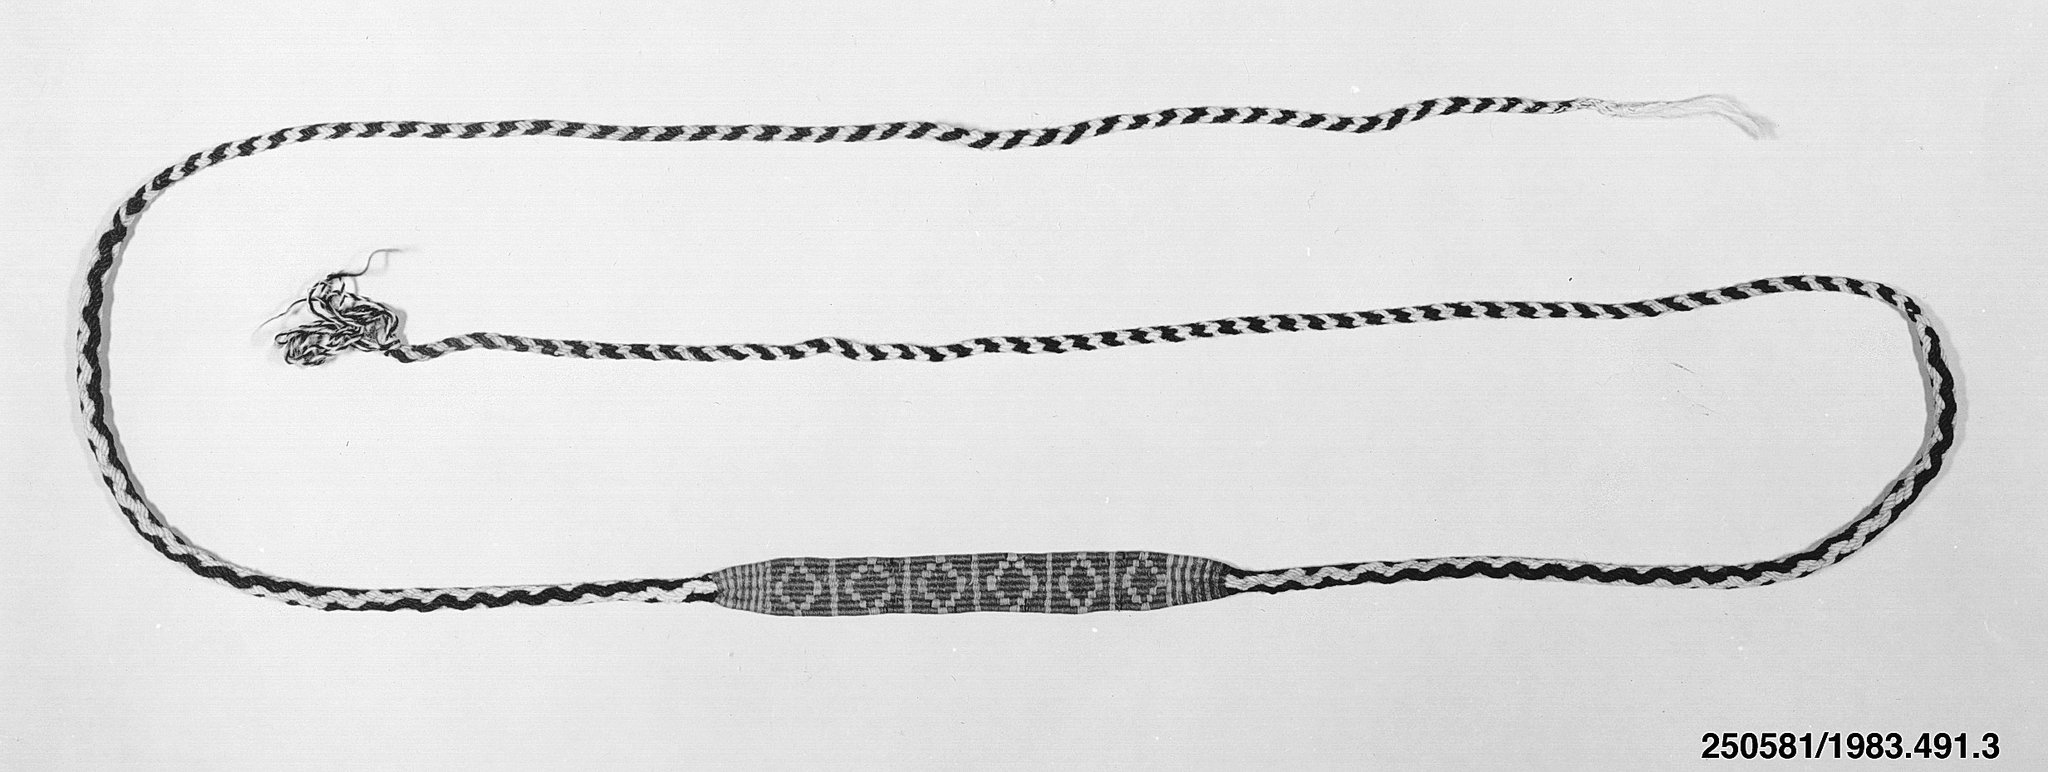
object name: sling shot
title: Woven Sling Shot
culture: inca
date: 1301-1600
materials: animal fiber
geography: peru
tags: weapons